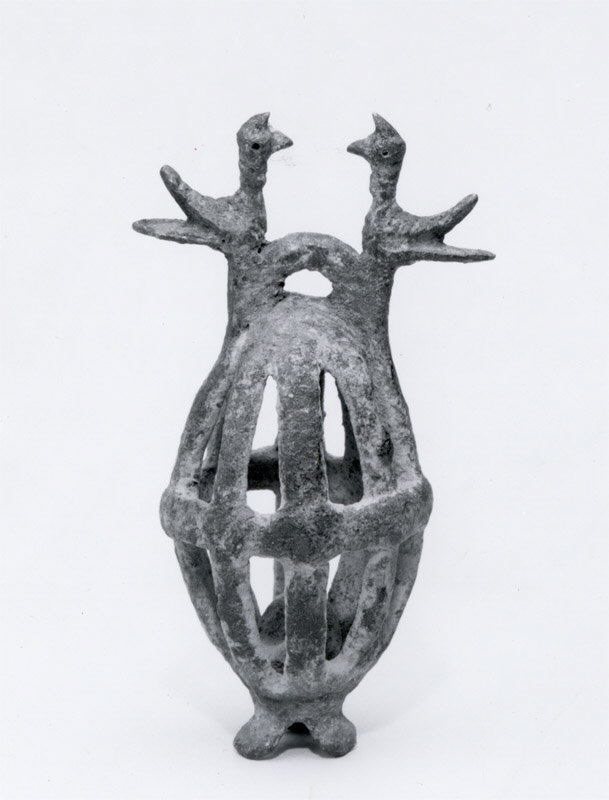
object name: rattle bell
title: Openwork rattle bell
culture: iranian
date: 900-701 BCE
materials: bronze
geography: western iran